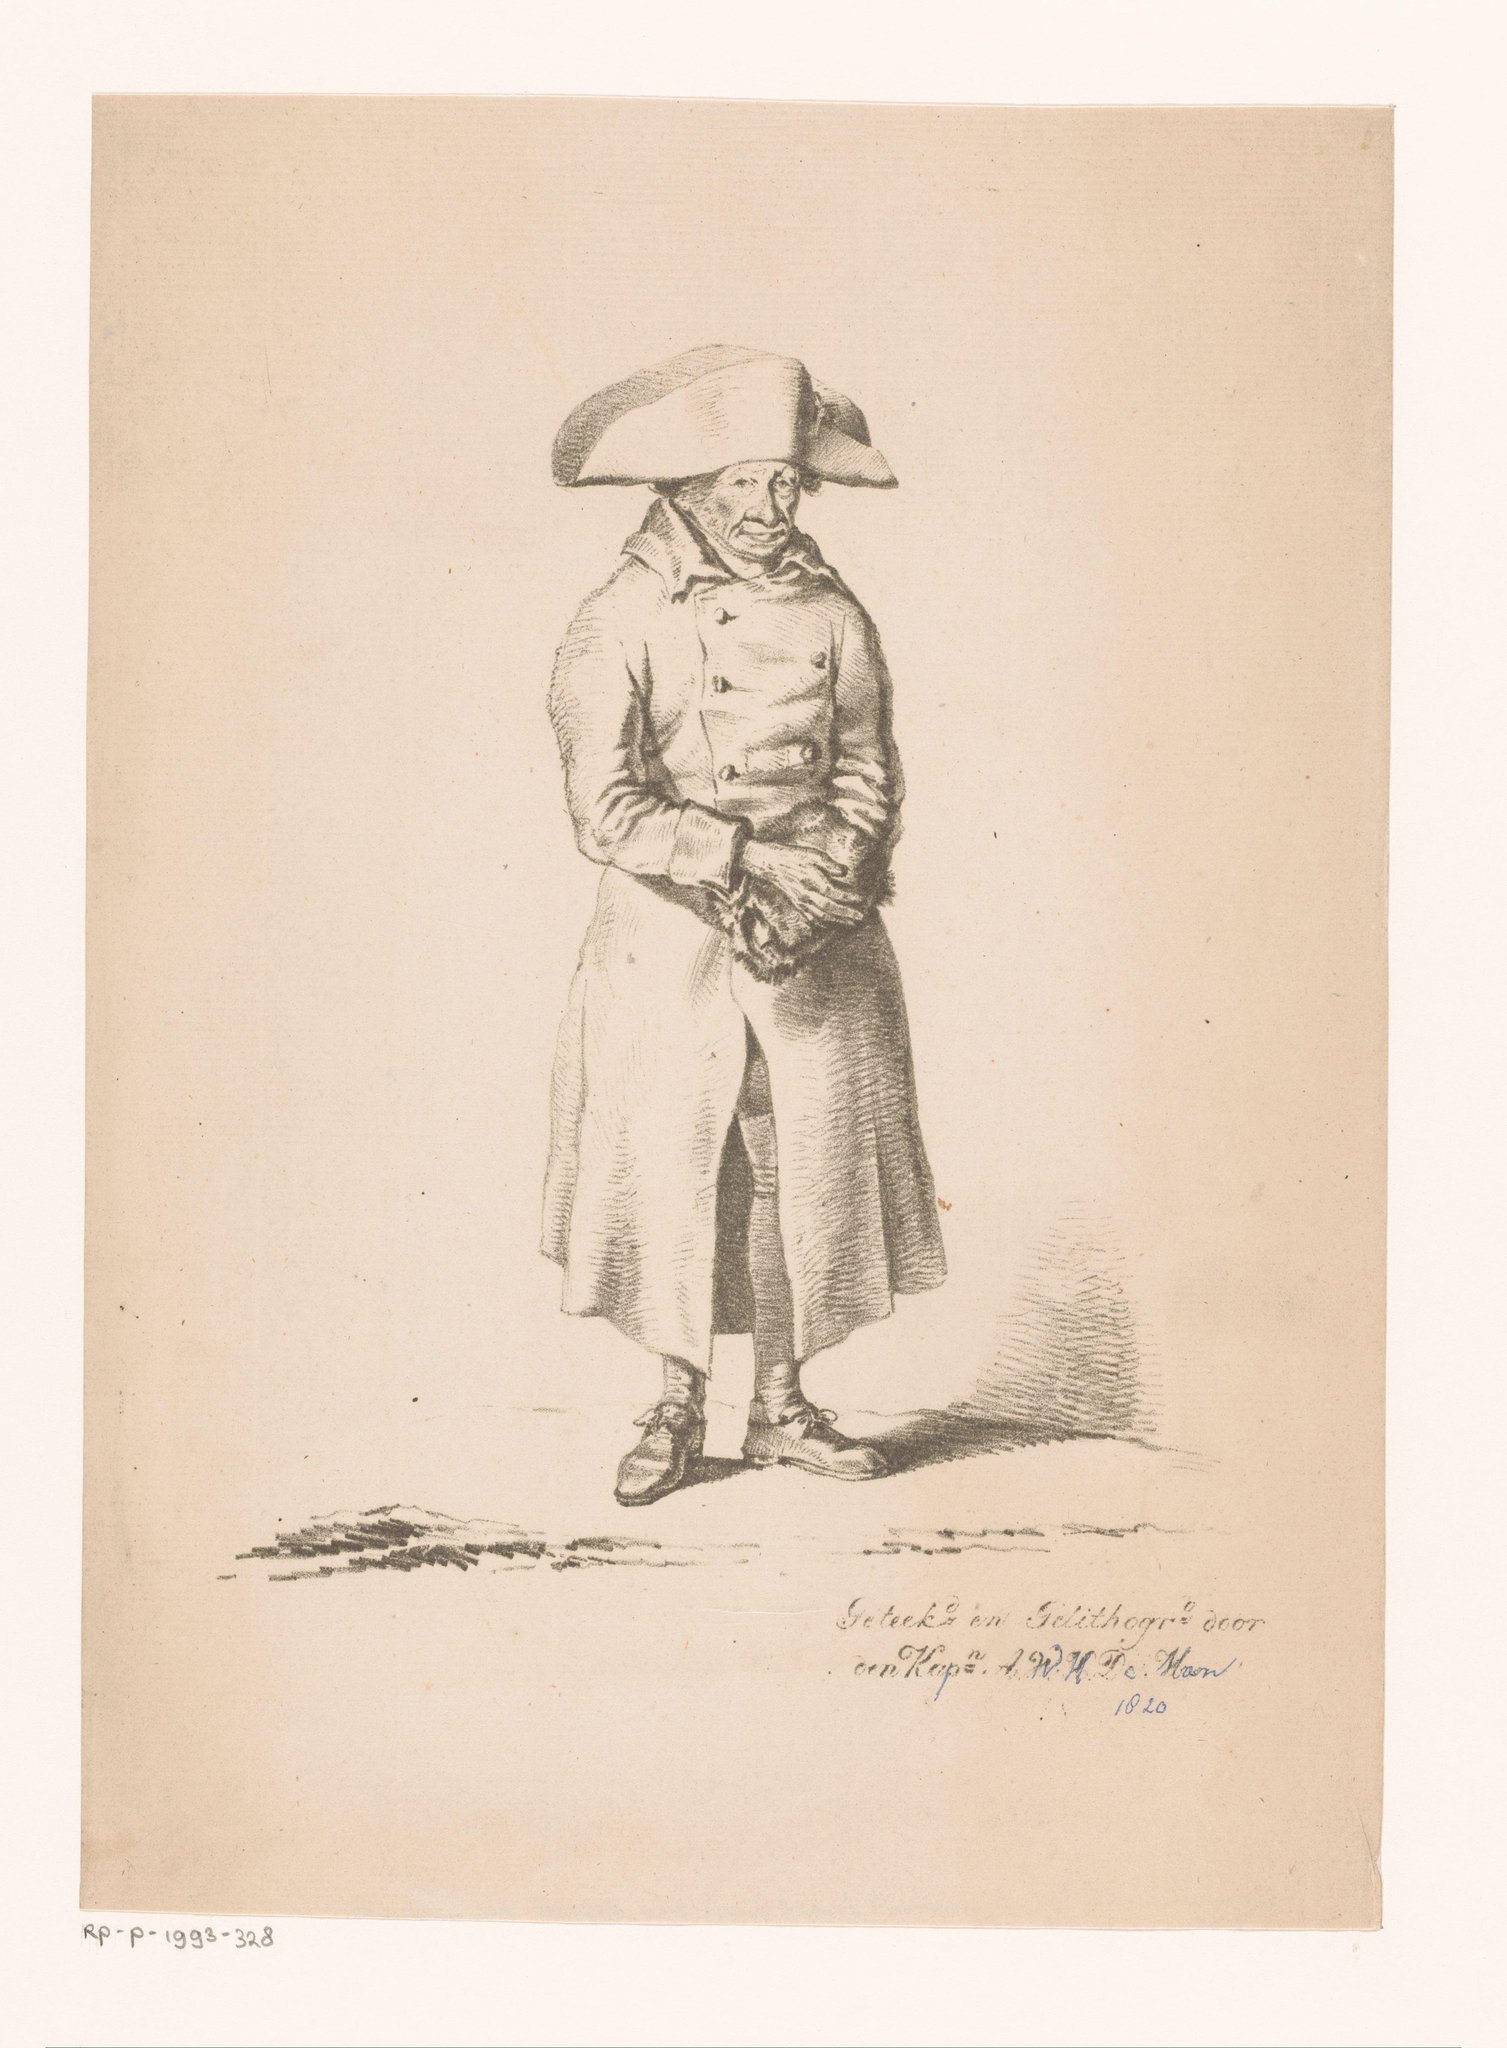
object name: print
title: Portret van Aron-Eliazer Cohen, bijgenaamd Aron Dantzig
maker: anthonie willem hendrik nolthenius de man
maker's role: draughtsman, print maker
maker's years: 1793-1842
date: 1820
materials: ball point pen, paper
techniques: lithograph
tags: head-gear: bicorne, bicorn, muff, historical persons (+ full length portrait)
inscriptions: collector's mark: Lugt 2228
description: De geportretteerde draagt een steek op het hoofd en heeft zijn linkerhand in een mof gestoken.